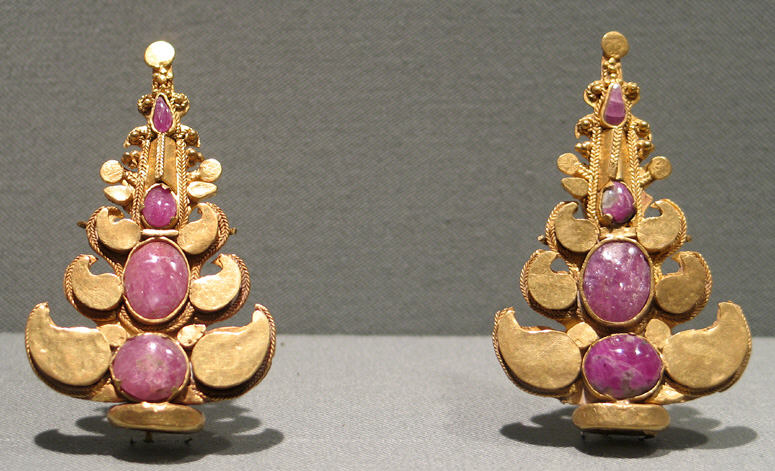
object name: crown element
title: Two Elements from a Crown with Inlaid Stones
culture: indonesian, javanese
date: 701-933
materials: gold, stone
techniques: inlay